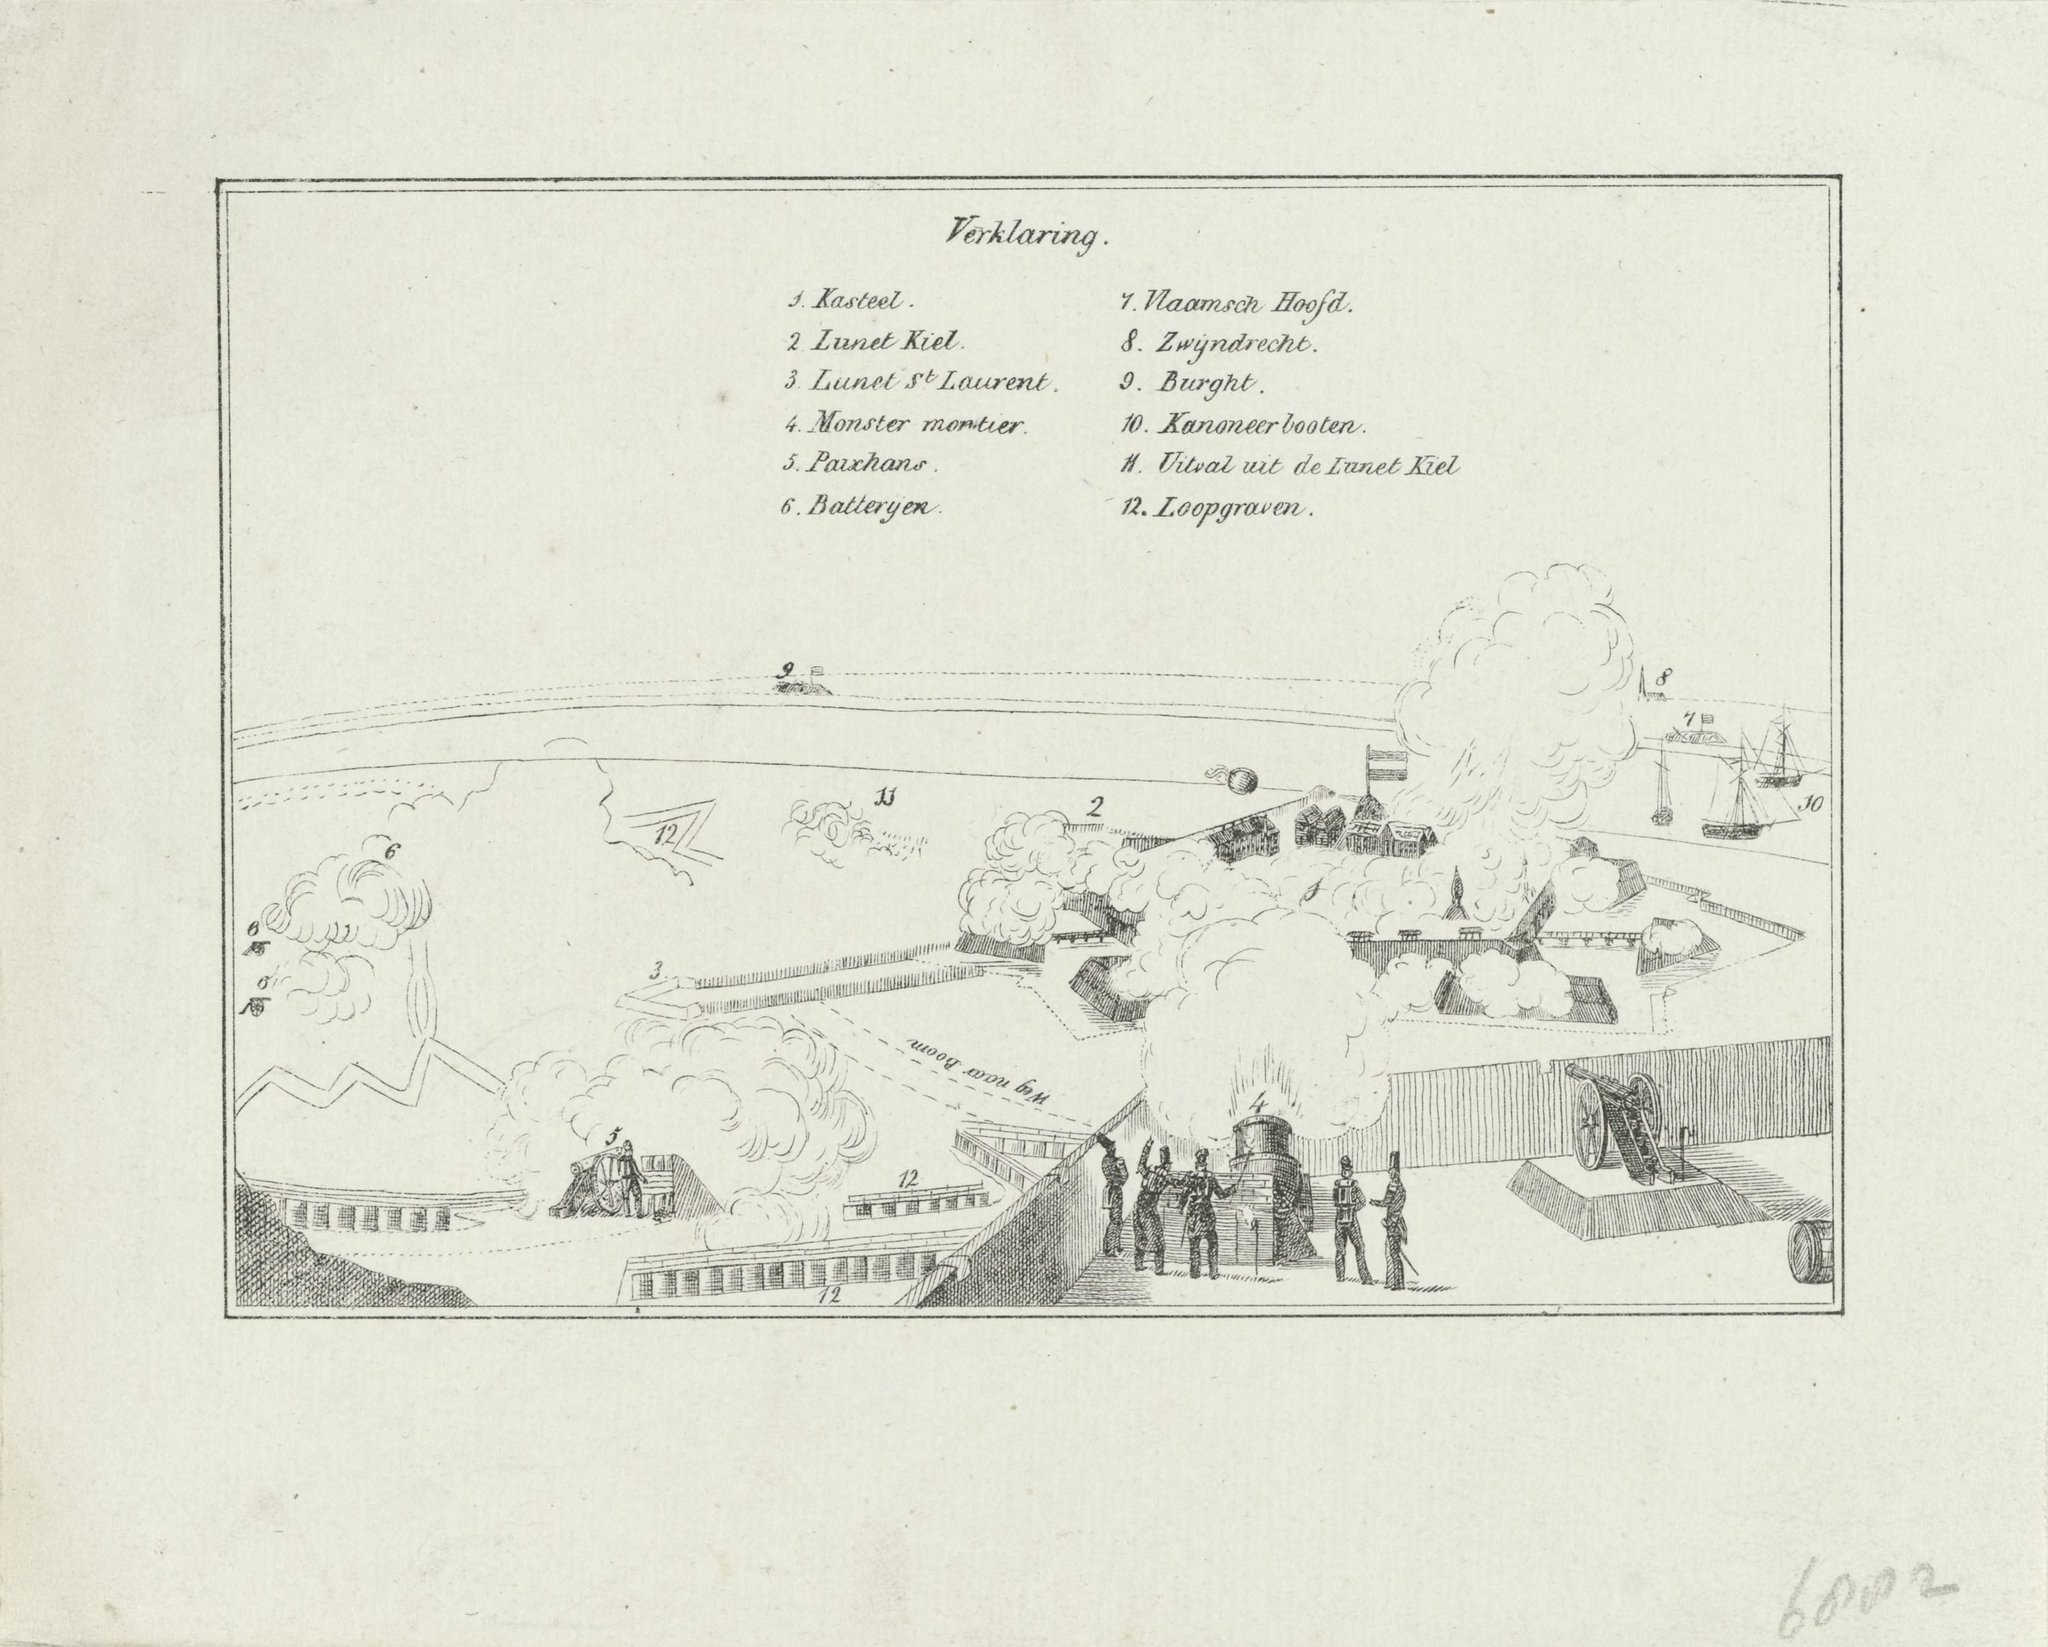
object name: print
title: Sleutel bij de prent van de belegering der Citadel van Antwerpen, december 1832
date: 1832-1833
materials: paper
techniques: lithograph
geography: netherlands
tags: firearms (with name), bombardment ~ siege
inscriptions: collector's mark: Lugt 2228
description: Sleutel of verklaring van de voorstelling van de prent van het bombardement van de Citadel van Antwerpen, 20-23 december 1832. Bovenaan de legenda 1-12.